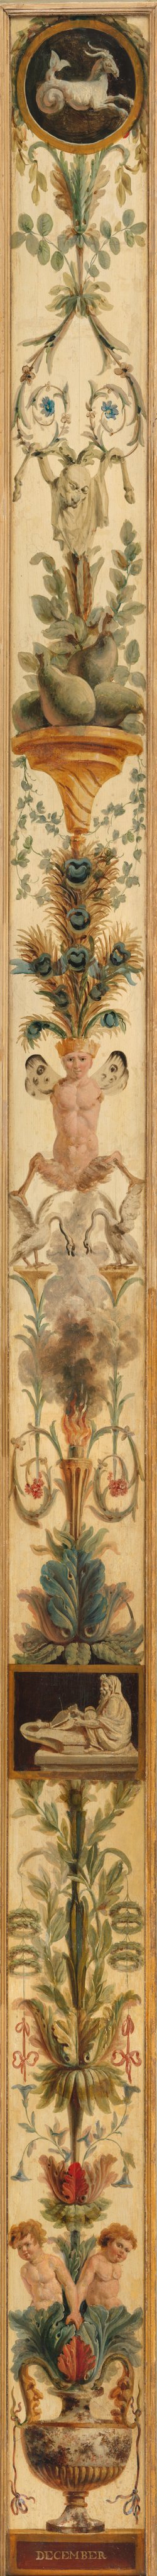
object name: decoratiestuk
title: December, with the Sign of Capricorn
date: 1790-1791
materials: oil, panel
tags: ornament ~ grotesque, december ~ other concepts (+ with signs or personifications of the planets together with zodiacal signs)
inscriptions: inscription: ‘December’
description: Negen maanden met de tekens van de dierenriem: December met het teken van de steenbok. Maakt deel uit van een groep decoraties met grotesken afkomstig uit het huis van J.A. Brentano aan de Herengracht. Waarschijnlijk vervaardigd naar ontwerpen van Giambattista Maderna.